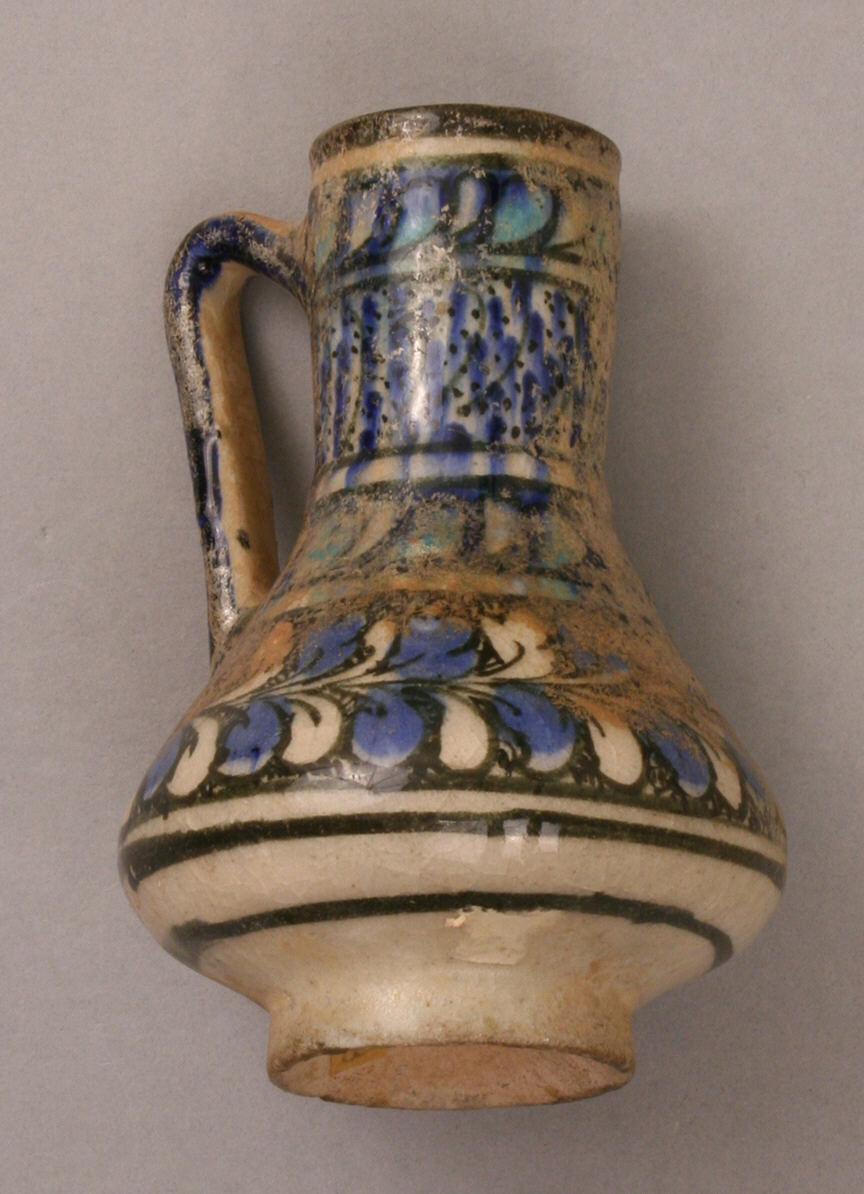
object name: ewer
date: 1301-1400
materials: stonepaste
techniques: painting, underglaze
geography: iran